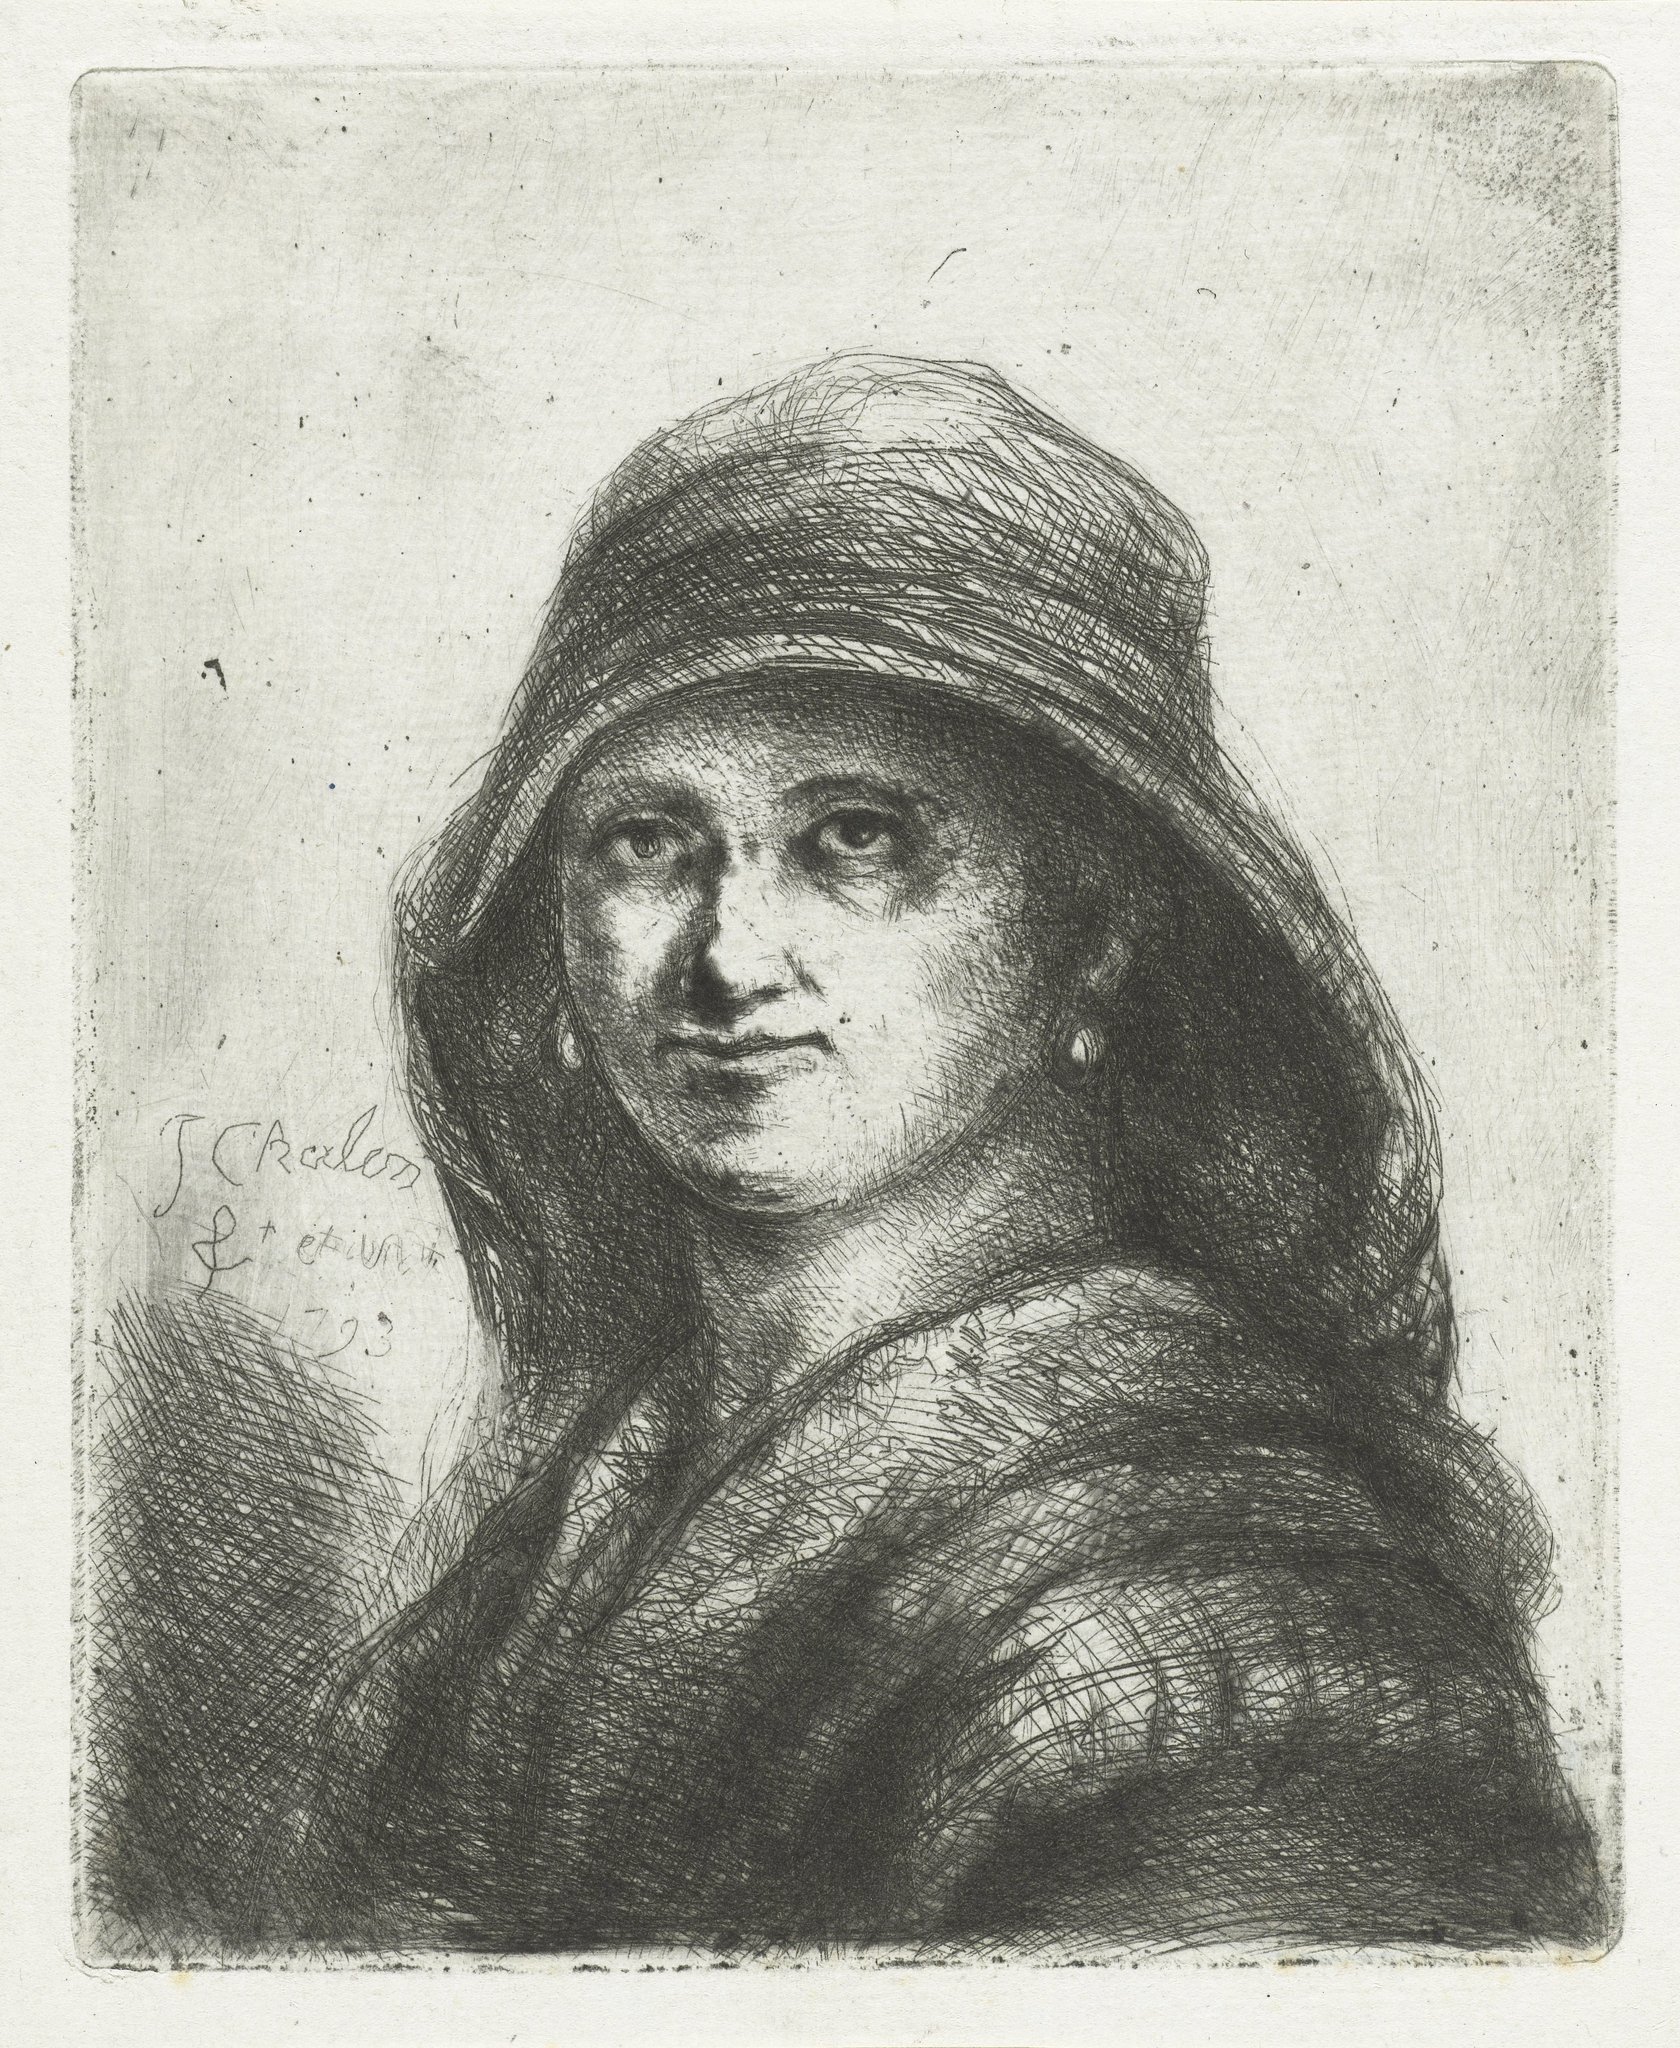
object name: print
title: Vrouw met capuchon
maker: jan chalon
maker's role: print maker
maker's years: 1738-1795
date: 1793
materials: paper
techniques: drypoint, etching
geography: northern netherlands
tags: head-gear: hood, morphology of human expression (+ adult female (human being))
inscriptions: collector's mark: Lugt 924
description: Een jonge vrouw. Buste naar links. Ze draagt een capuchon over haar hoofd.